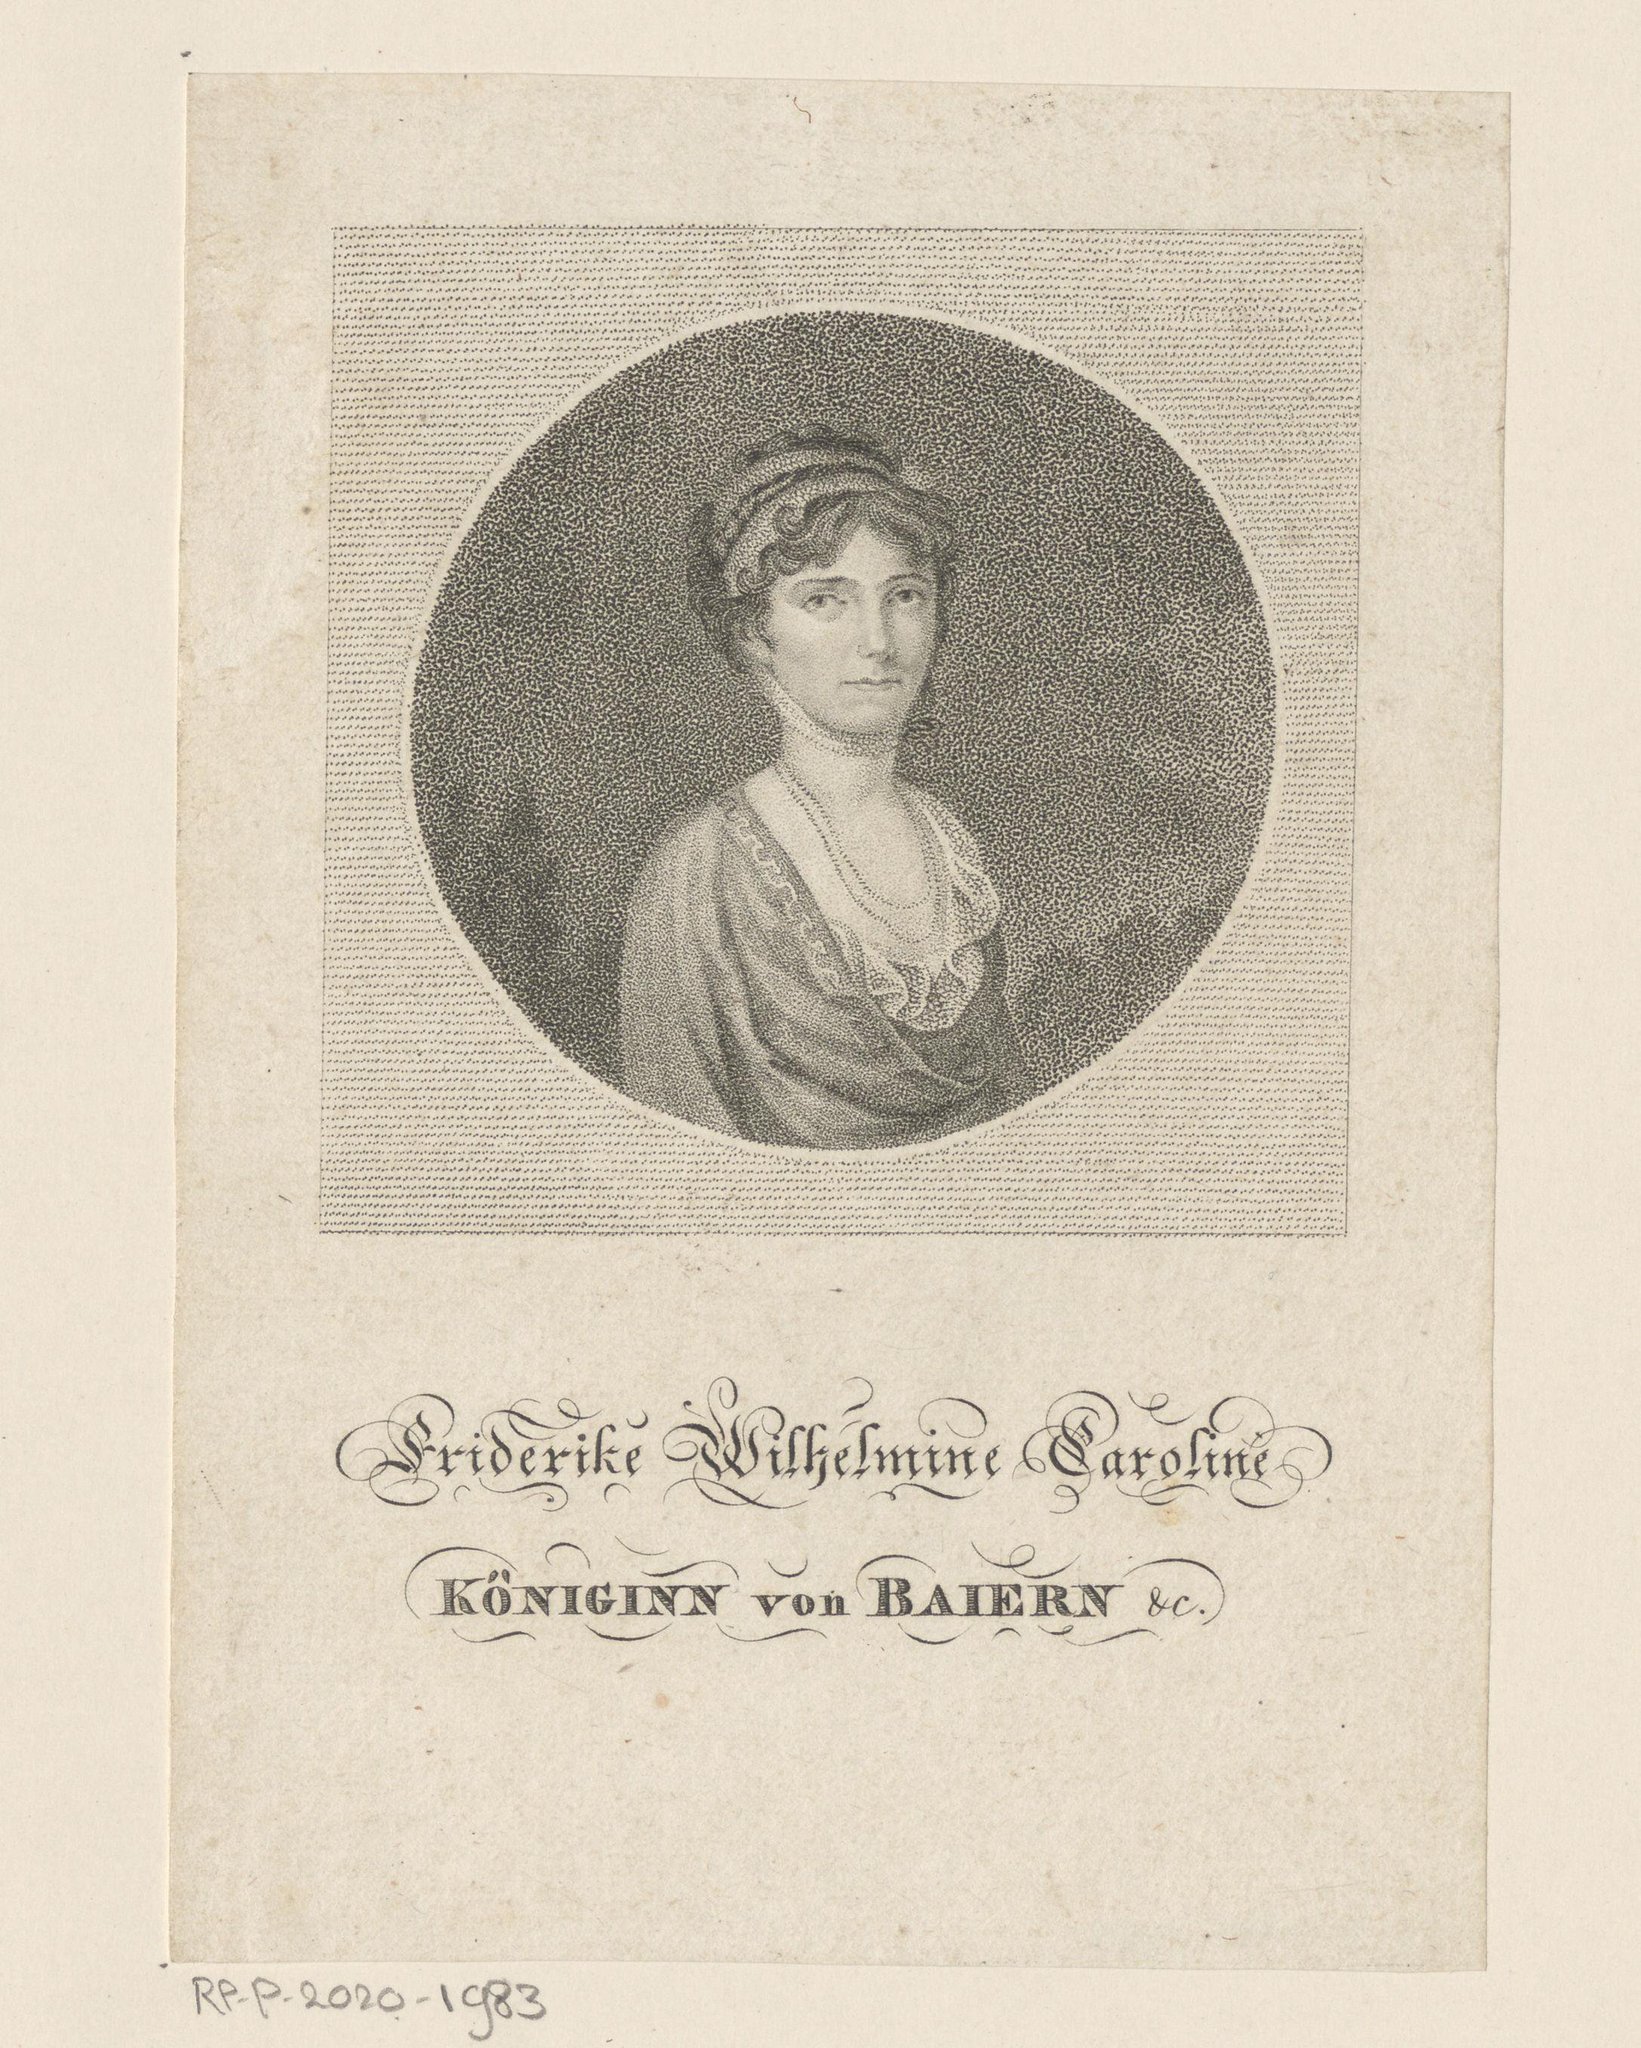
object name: print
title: Portret van Caroline van Baden, koningin van Beieren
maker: Anonymous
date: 1803-1879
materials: paper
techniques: engraving, etching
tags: historical persons - bb - woman, queen